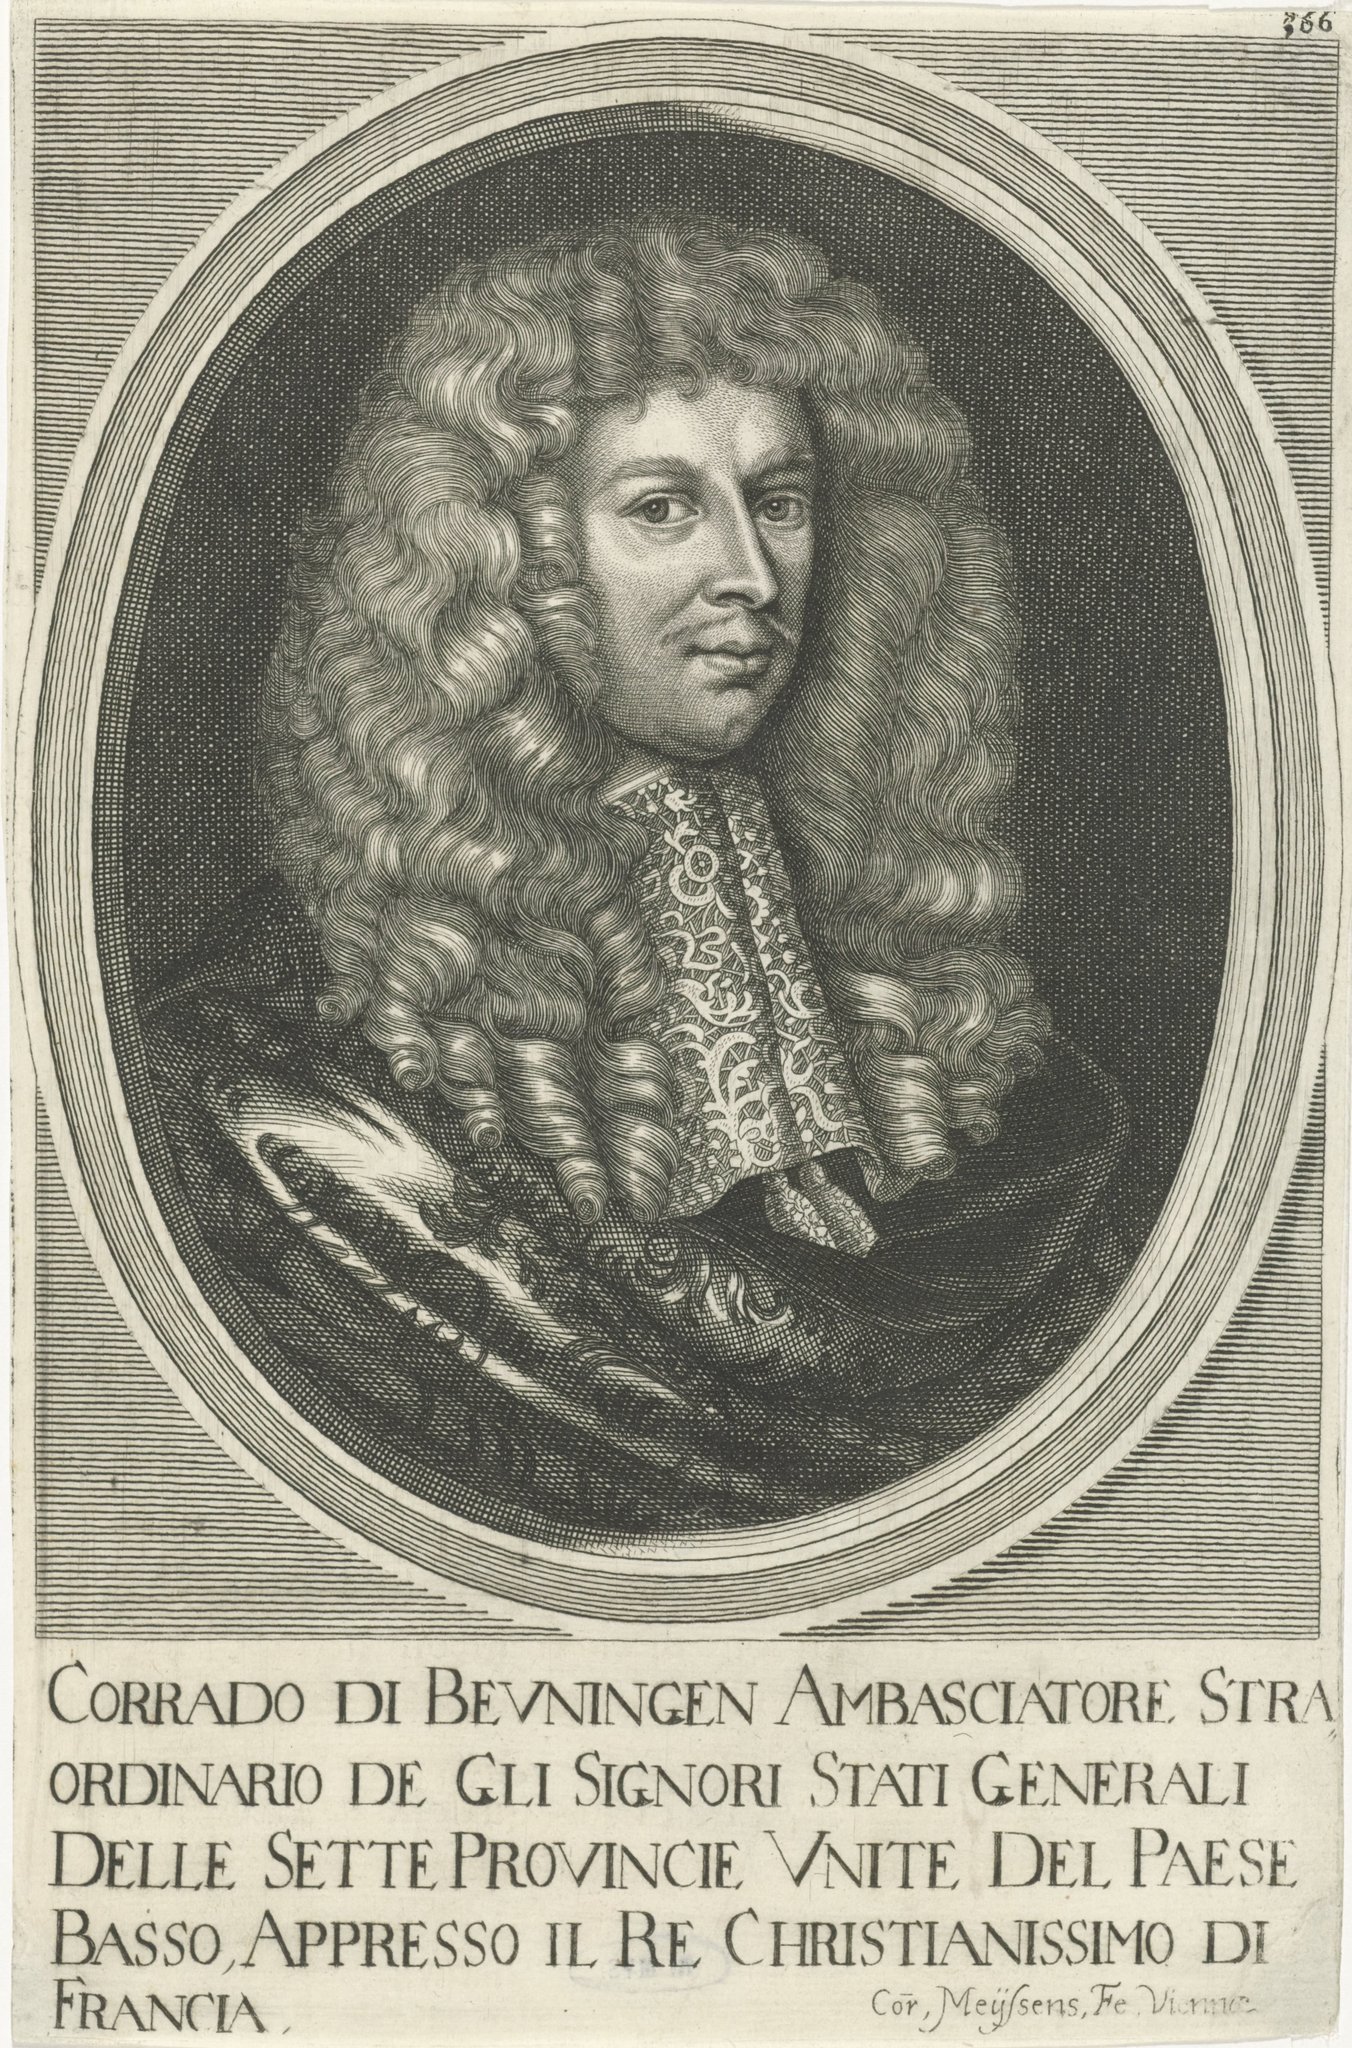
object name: print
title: Portret van Koenraad van Beuningen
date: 1670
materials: paper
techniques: engraving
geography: vienna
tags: koenraad van beuningen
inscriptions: collector's mark: Lugt 2228, number: ‘366’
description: Prent gebruikt in: Gualdo Priorato, Galeazzo. Historia di Leopoldo Cesare, (...). 3 dln. Wenen, Giovanni Battista Hacque, 1670-1674, dl. 2.